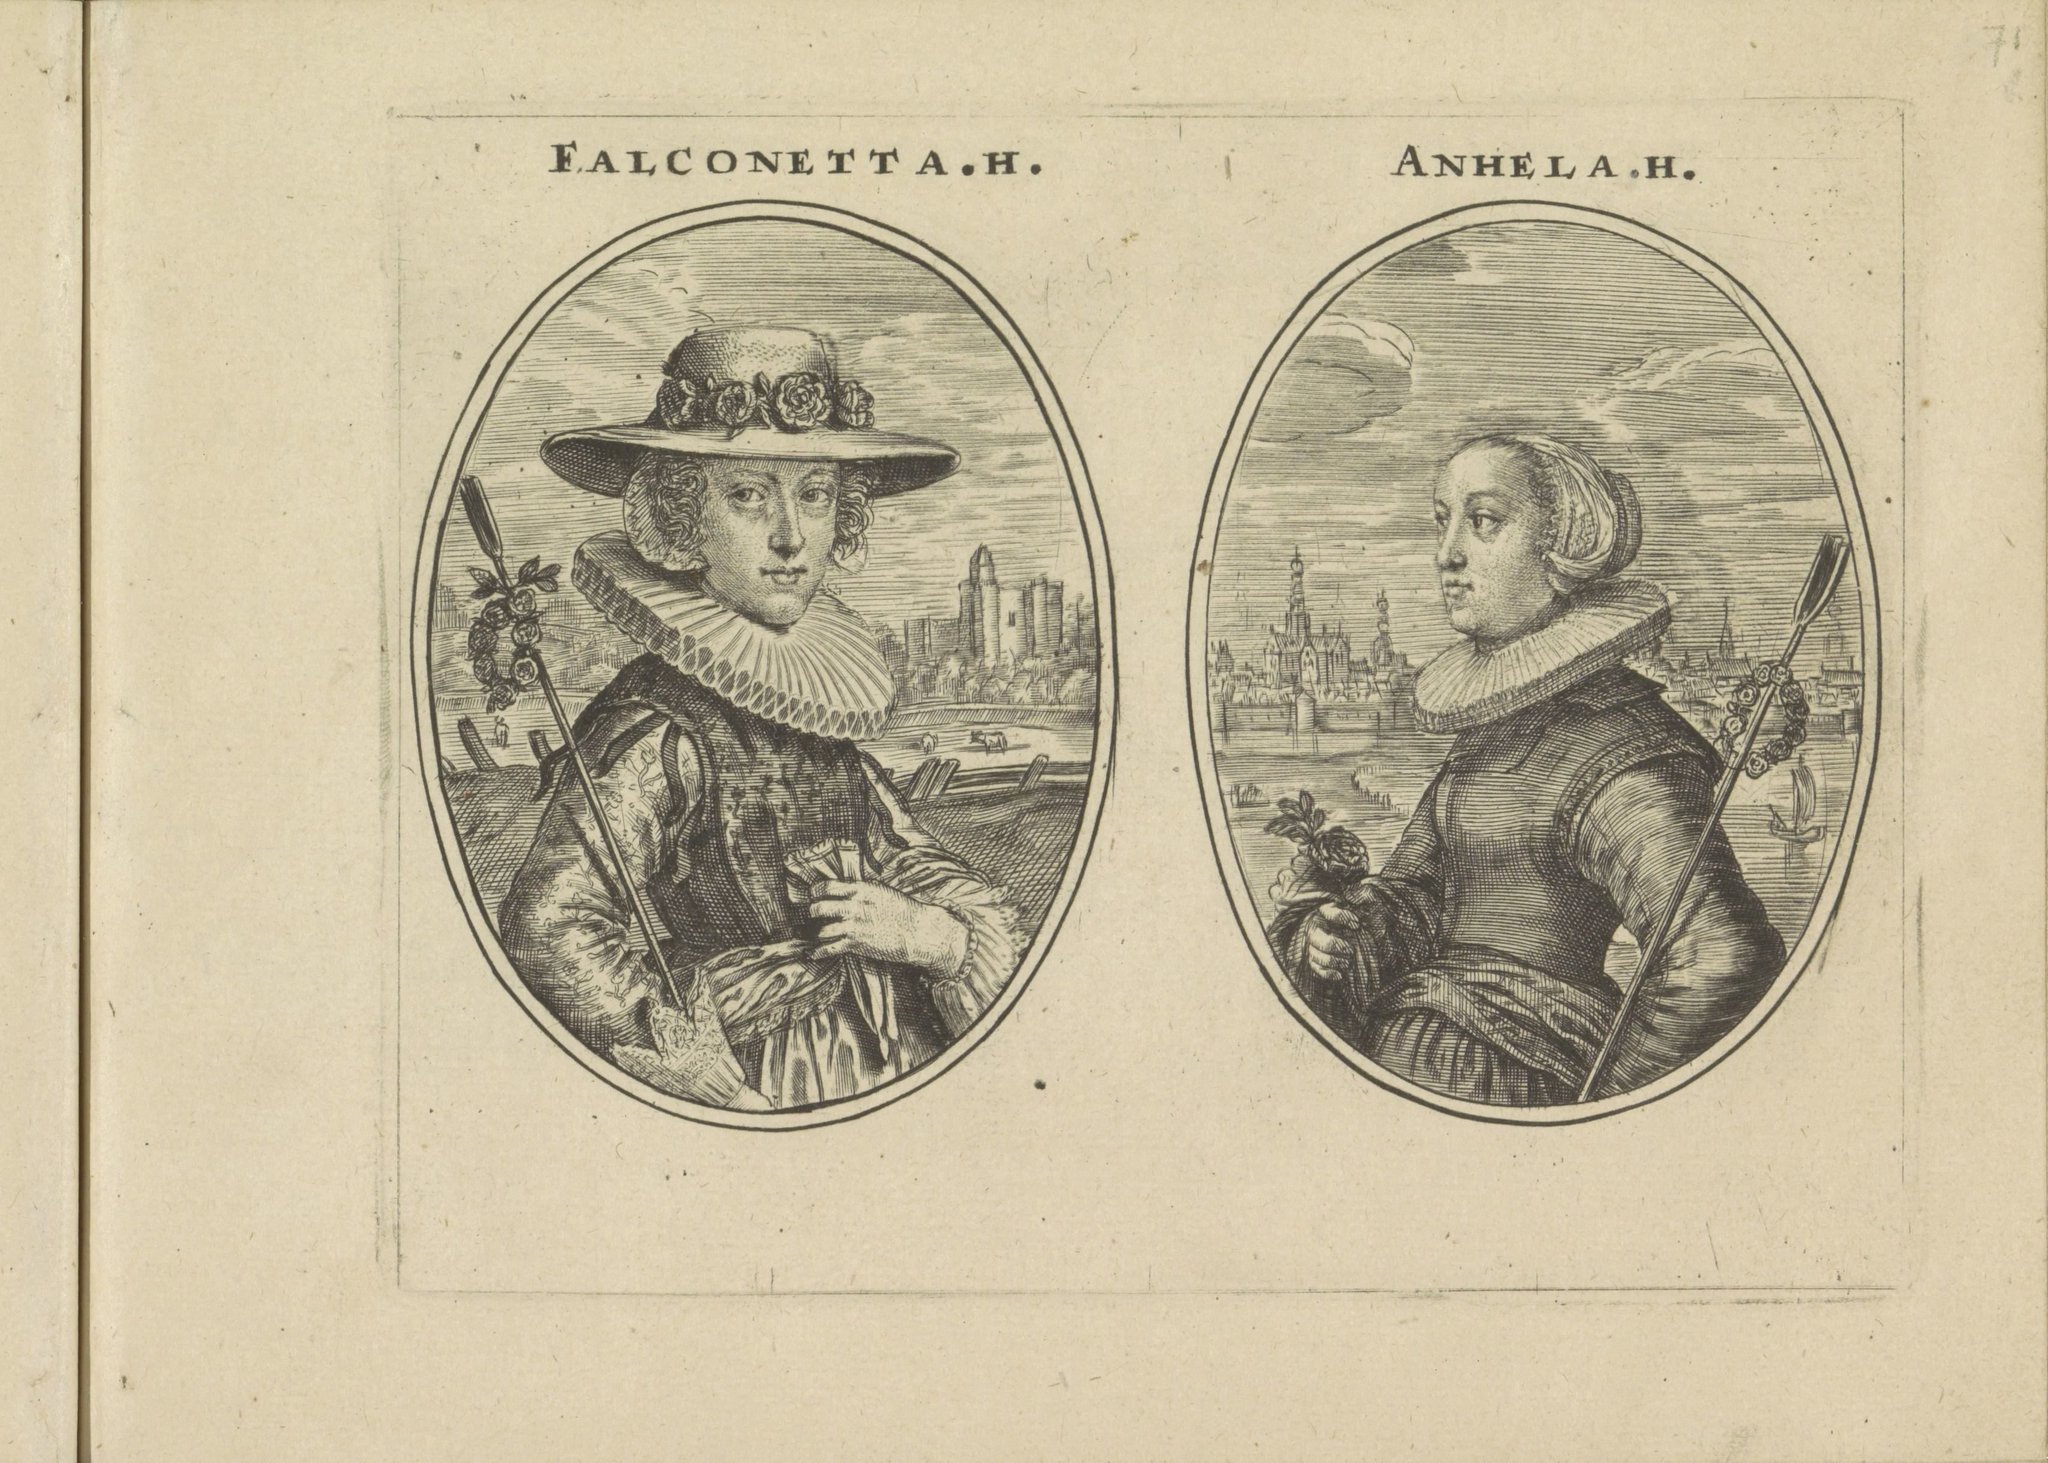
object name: album leaf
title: Portretten van twee onbekende vrouwen, beiden als herderin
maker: crispijn van de passe (ii)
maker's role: draughtsman, print maker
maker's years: 1594-1670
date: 1640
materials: paper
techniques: engraving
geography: amsterdam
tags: female sex; woman, shepherd's crook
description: Twee voorstellingen op een albumblad. Portretten van twee onbekende vrouwen uit Haarlem, beiden met herdersstaf, als Falconetta H. en Anhela H. Op de achtergrond van de twee portretten een stadsgezicht. Het blad maakt deel uit van een album.